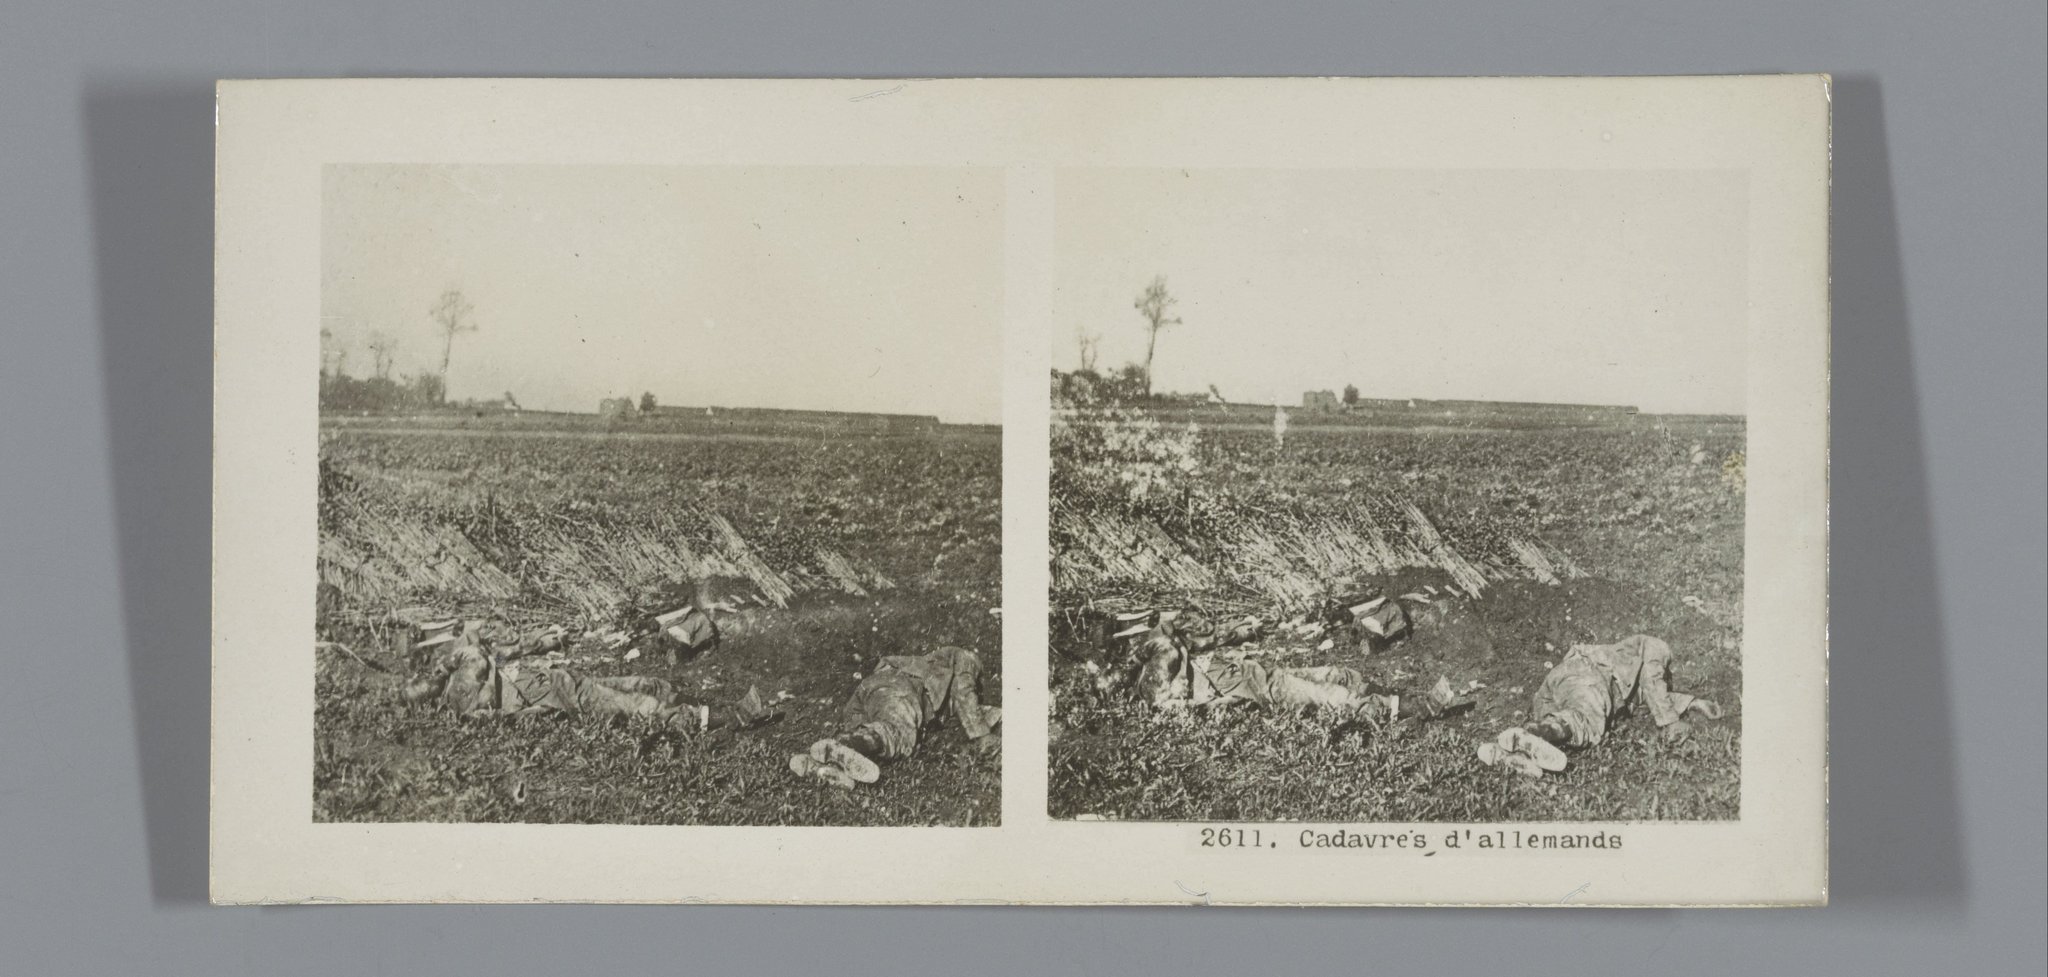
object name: stereograph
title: Omgekomen Duitse soldaten in een weiland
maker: Anonymous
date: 1914-1918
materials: cardboard, photographic support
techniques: gelatin silver print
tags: private soldier, the corpse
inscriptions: number: ‘2611.’